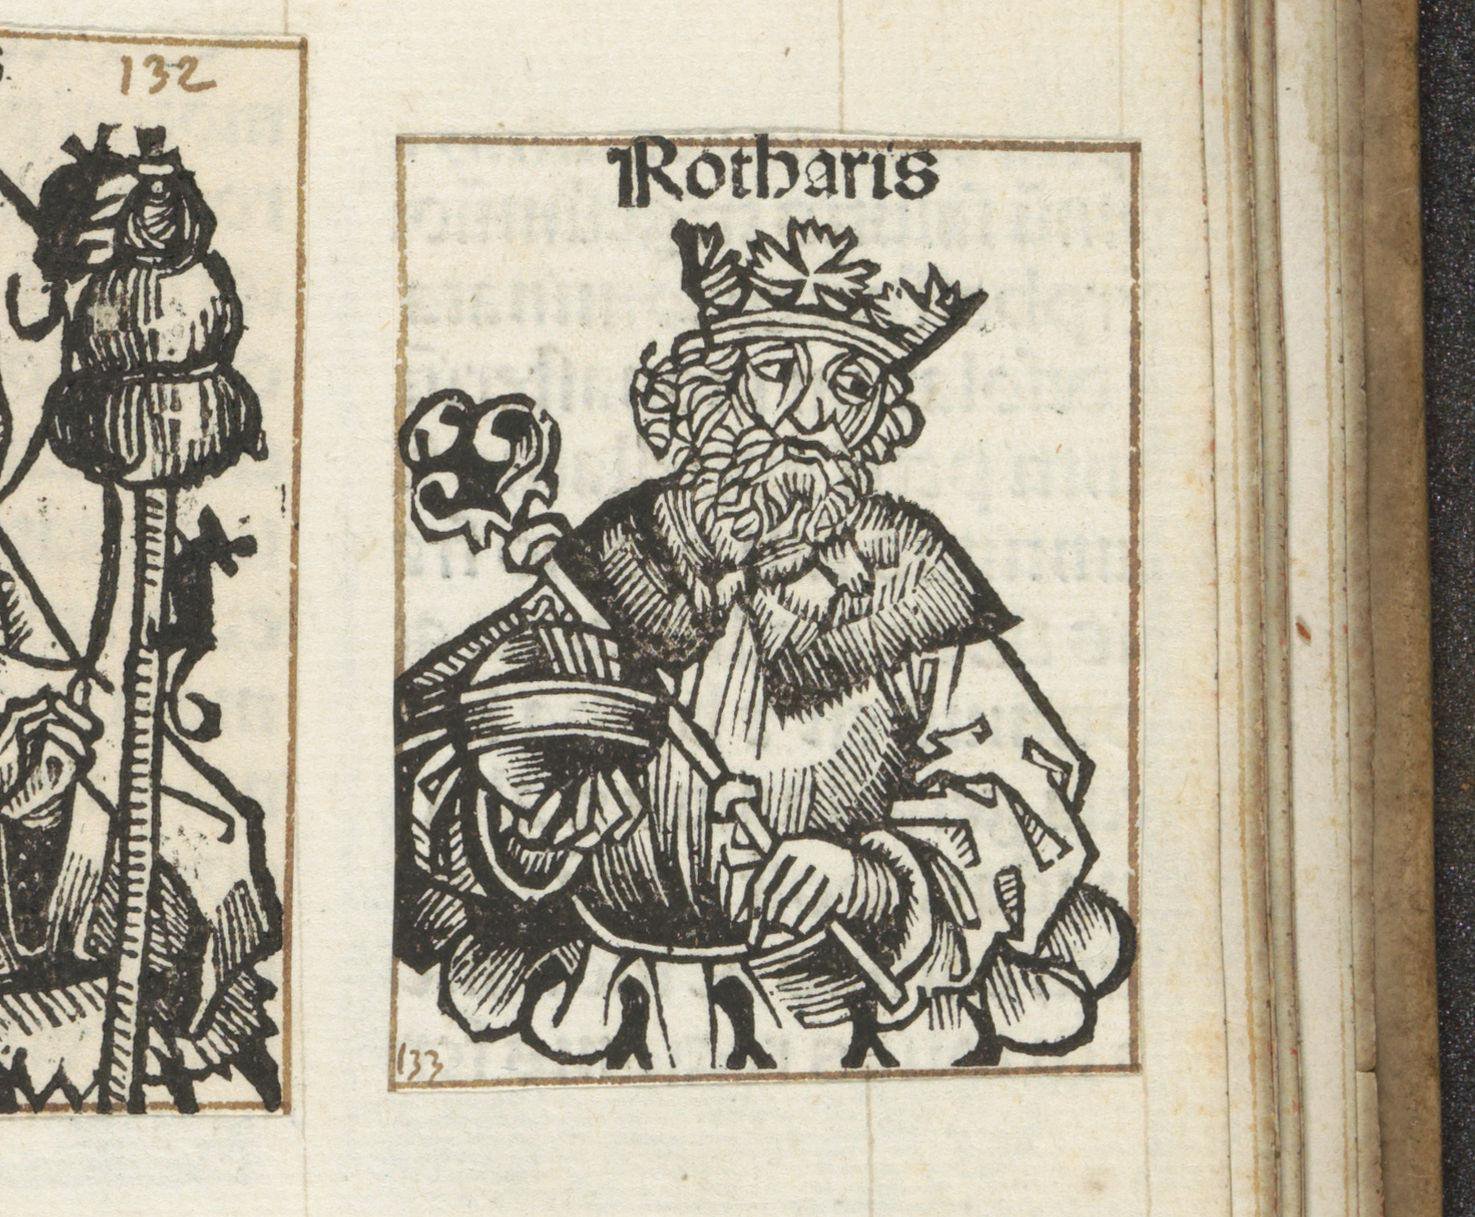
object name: album leaf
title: Liber Chronicarum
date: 1493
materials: paper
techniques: letterpress printing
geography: nuremberg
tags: king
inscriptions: inscription: ‘133’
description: De houtsnede wordt herhaaldelijk gebruikt als boekillustratie in de Liber Chronicarum (of Neurenbergkroniek) van Hartmann Schedel, verschenen in het Latijn en Duits in 1493. Zie de Latijnse uitgave, folio 155r.